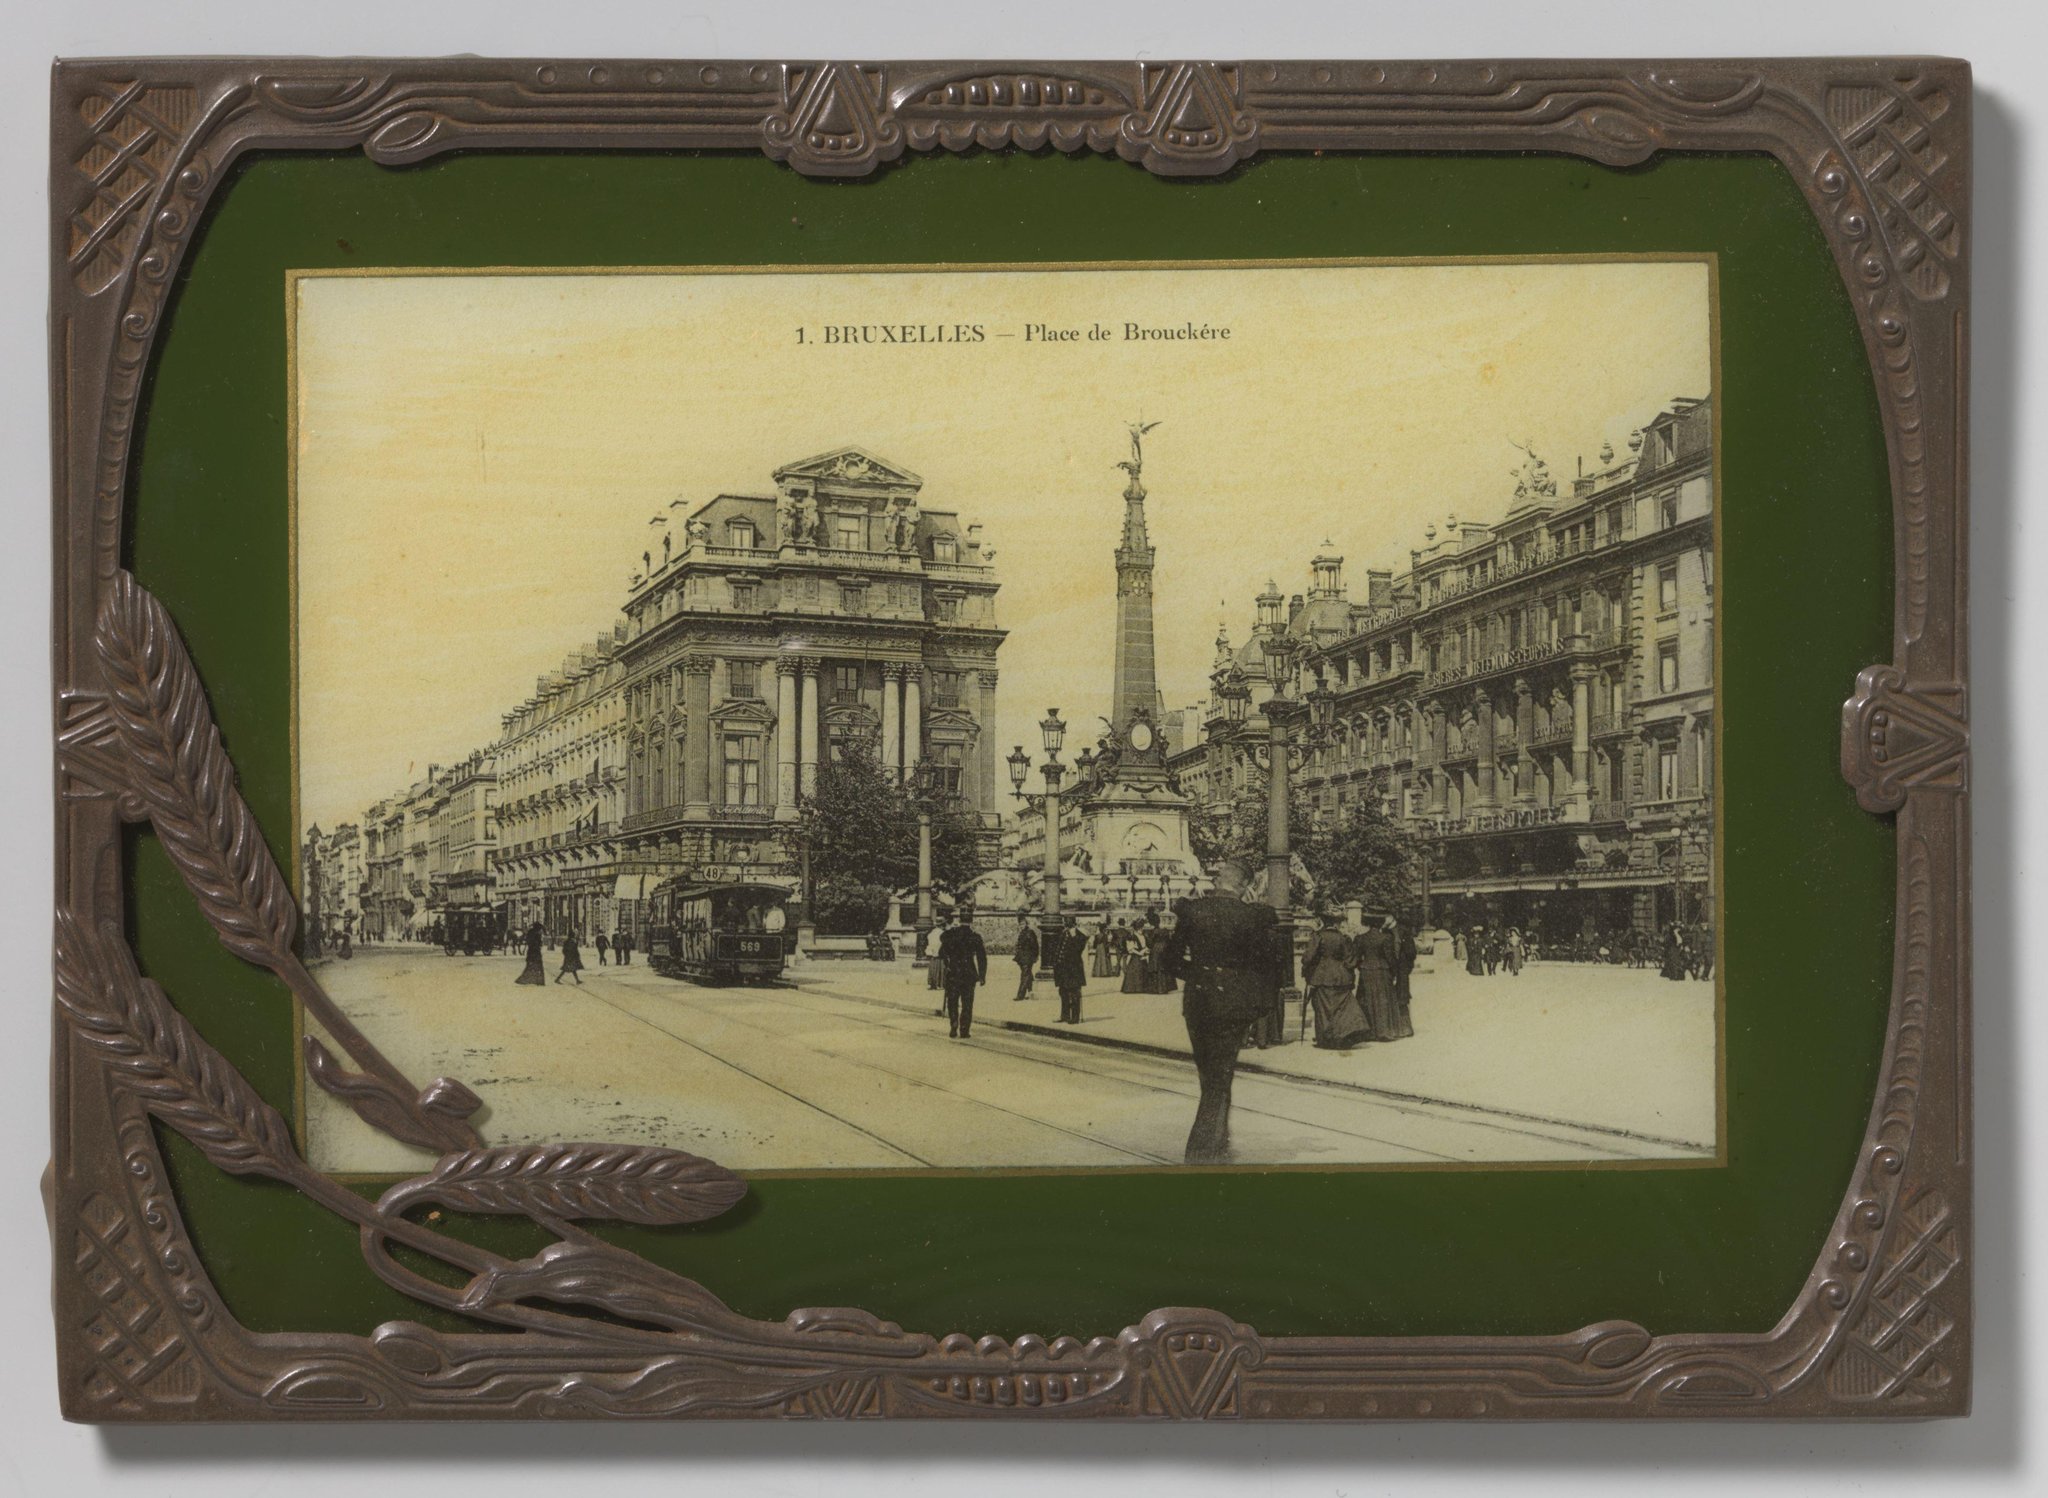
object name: photomechanical print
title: Gezicht op het Brouckèreplein in Brussel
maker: Anonymous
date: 1880-1900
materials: cardboard, glass, metal, paper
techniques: photograph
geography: brussels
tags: square, place, circus, etc.